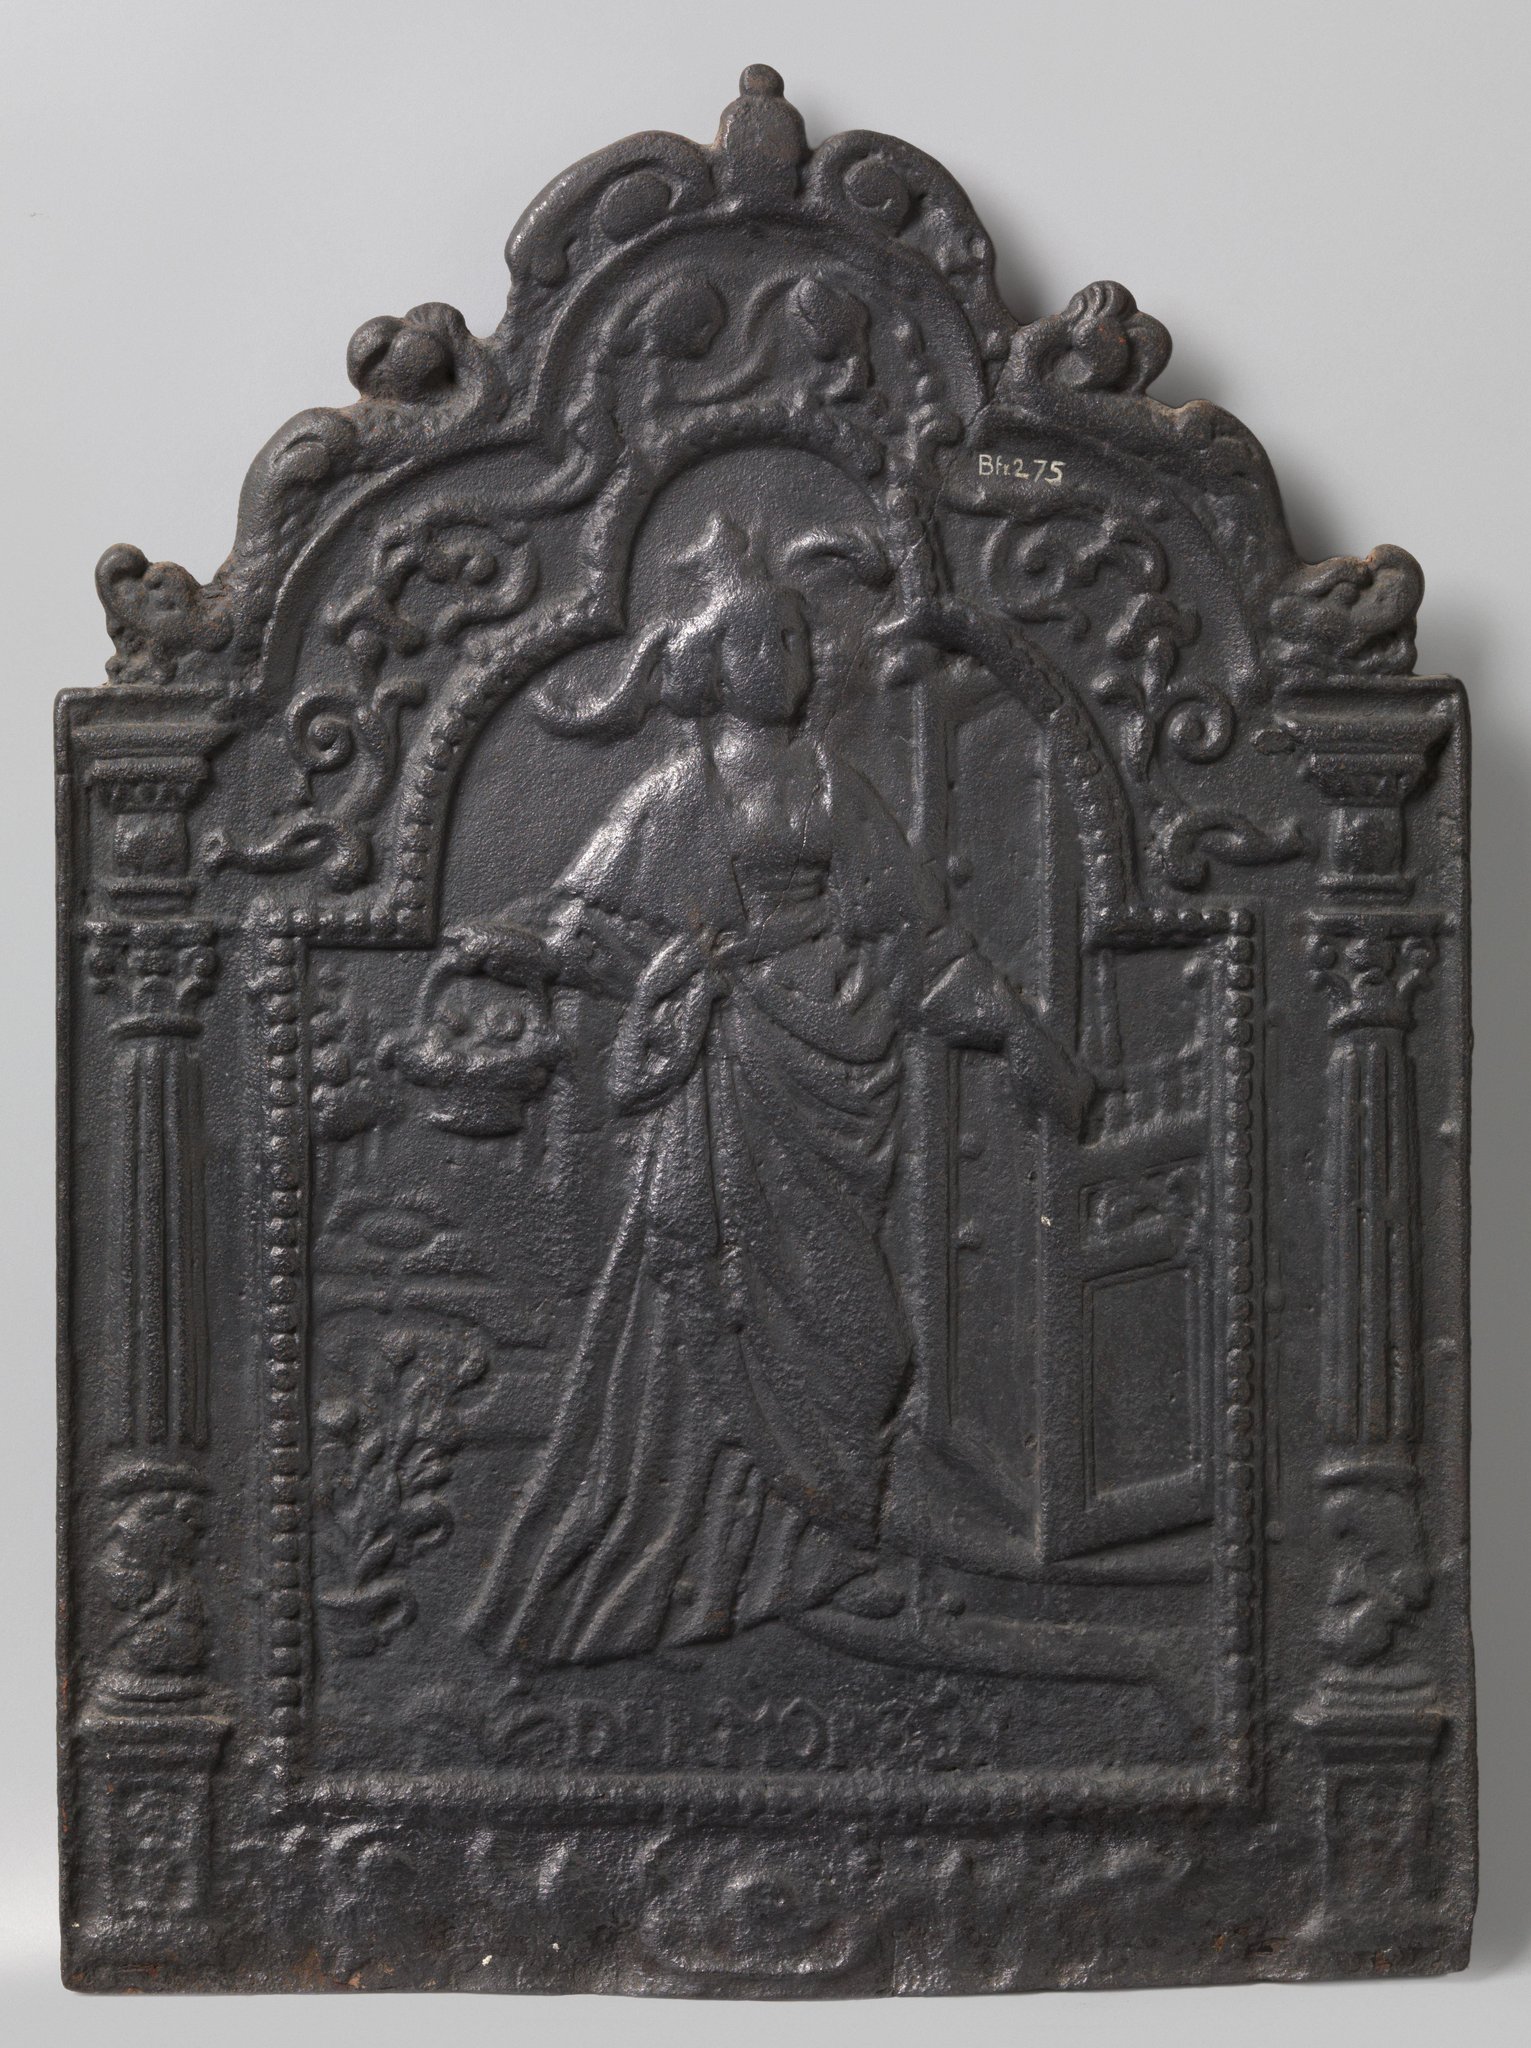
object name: fireback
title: Haardplaat met de Morgen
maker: Anonymous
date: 1675-1725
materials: iron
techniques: casting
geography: germany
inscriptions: inscription: ‘DER MORGEN’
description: Haardplaat van gietijzer, met een bovenzijde in driepasvorm. Centraal de personificatie van de Morgen, een staande vrouw met een mand in haar hand. Links van haar groeit een plant. Rechts staat poort (?). Onderaan het tafereel staat een opschrift DER MORGEN. Het geheel is omlijst met een rand, versierd met een parelrand en twee zuilen aan de zijkanten. De bovenzijde van de lijst heeft bladranken. TDe bovenzijde wordt bekroond met knop met aan weerszijden een C-voluut en een dolfijn.